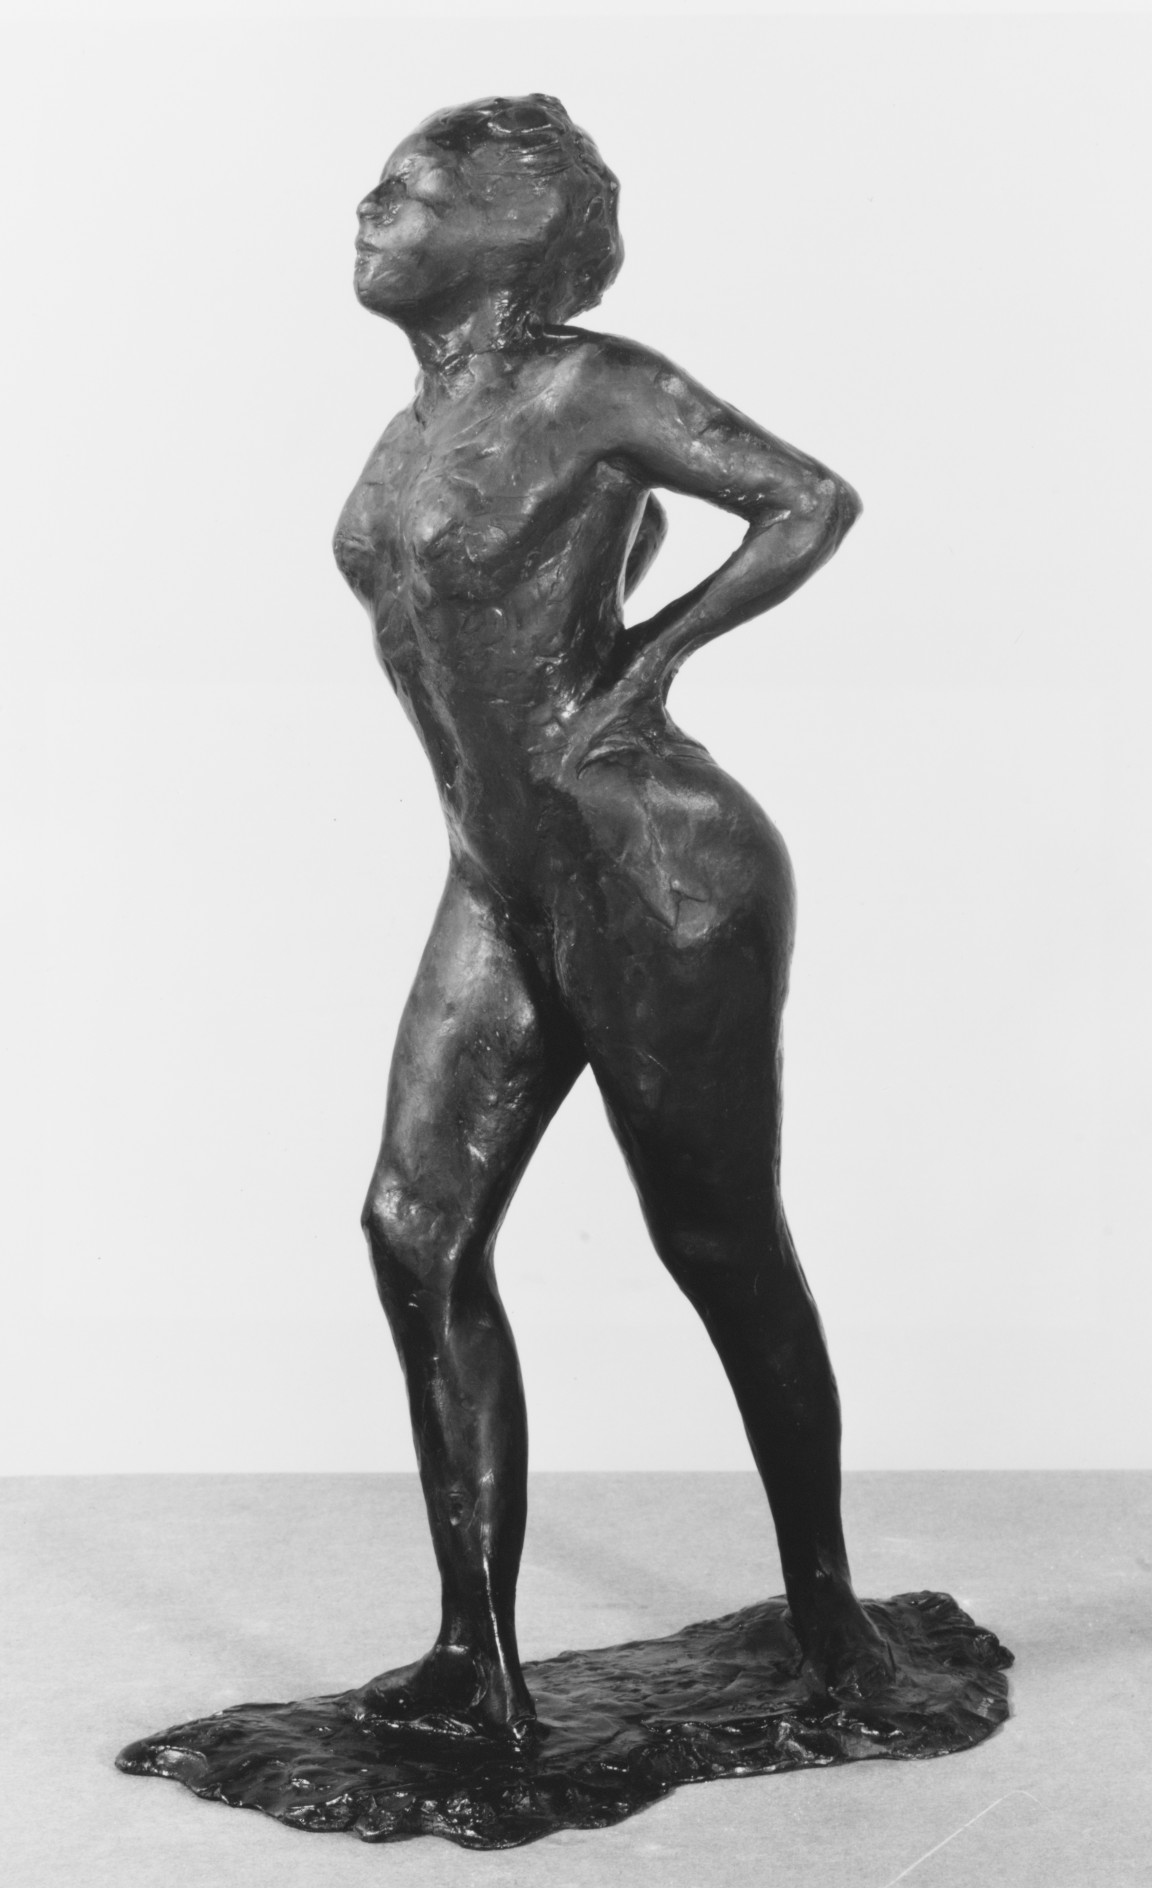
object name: statuette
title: Dancer at Rest, Hands Behind Her Back, Right Leg Forward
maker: edgar degas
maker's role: artist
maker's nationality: french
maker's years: 1834-1917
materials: bronze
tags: female nudes,dancers